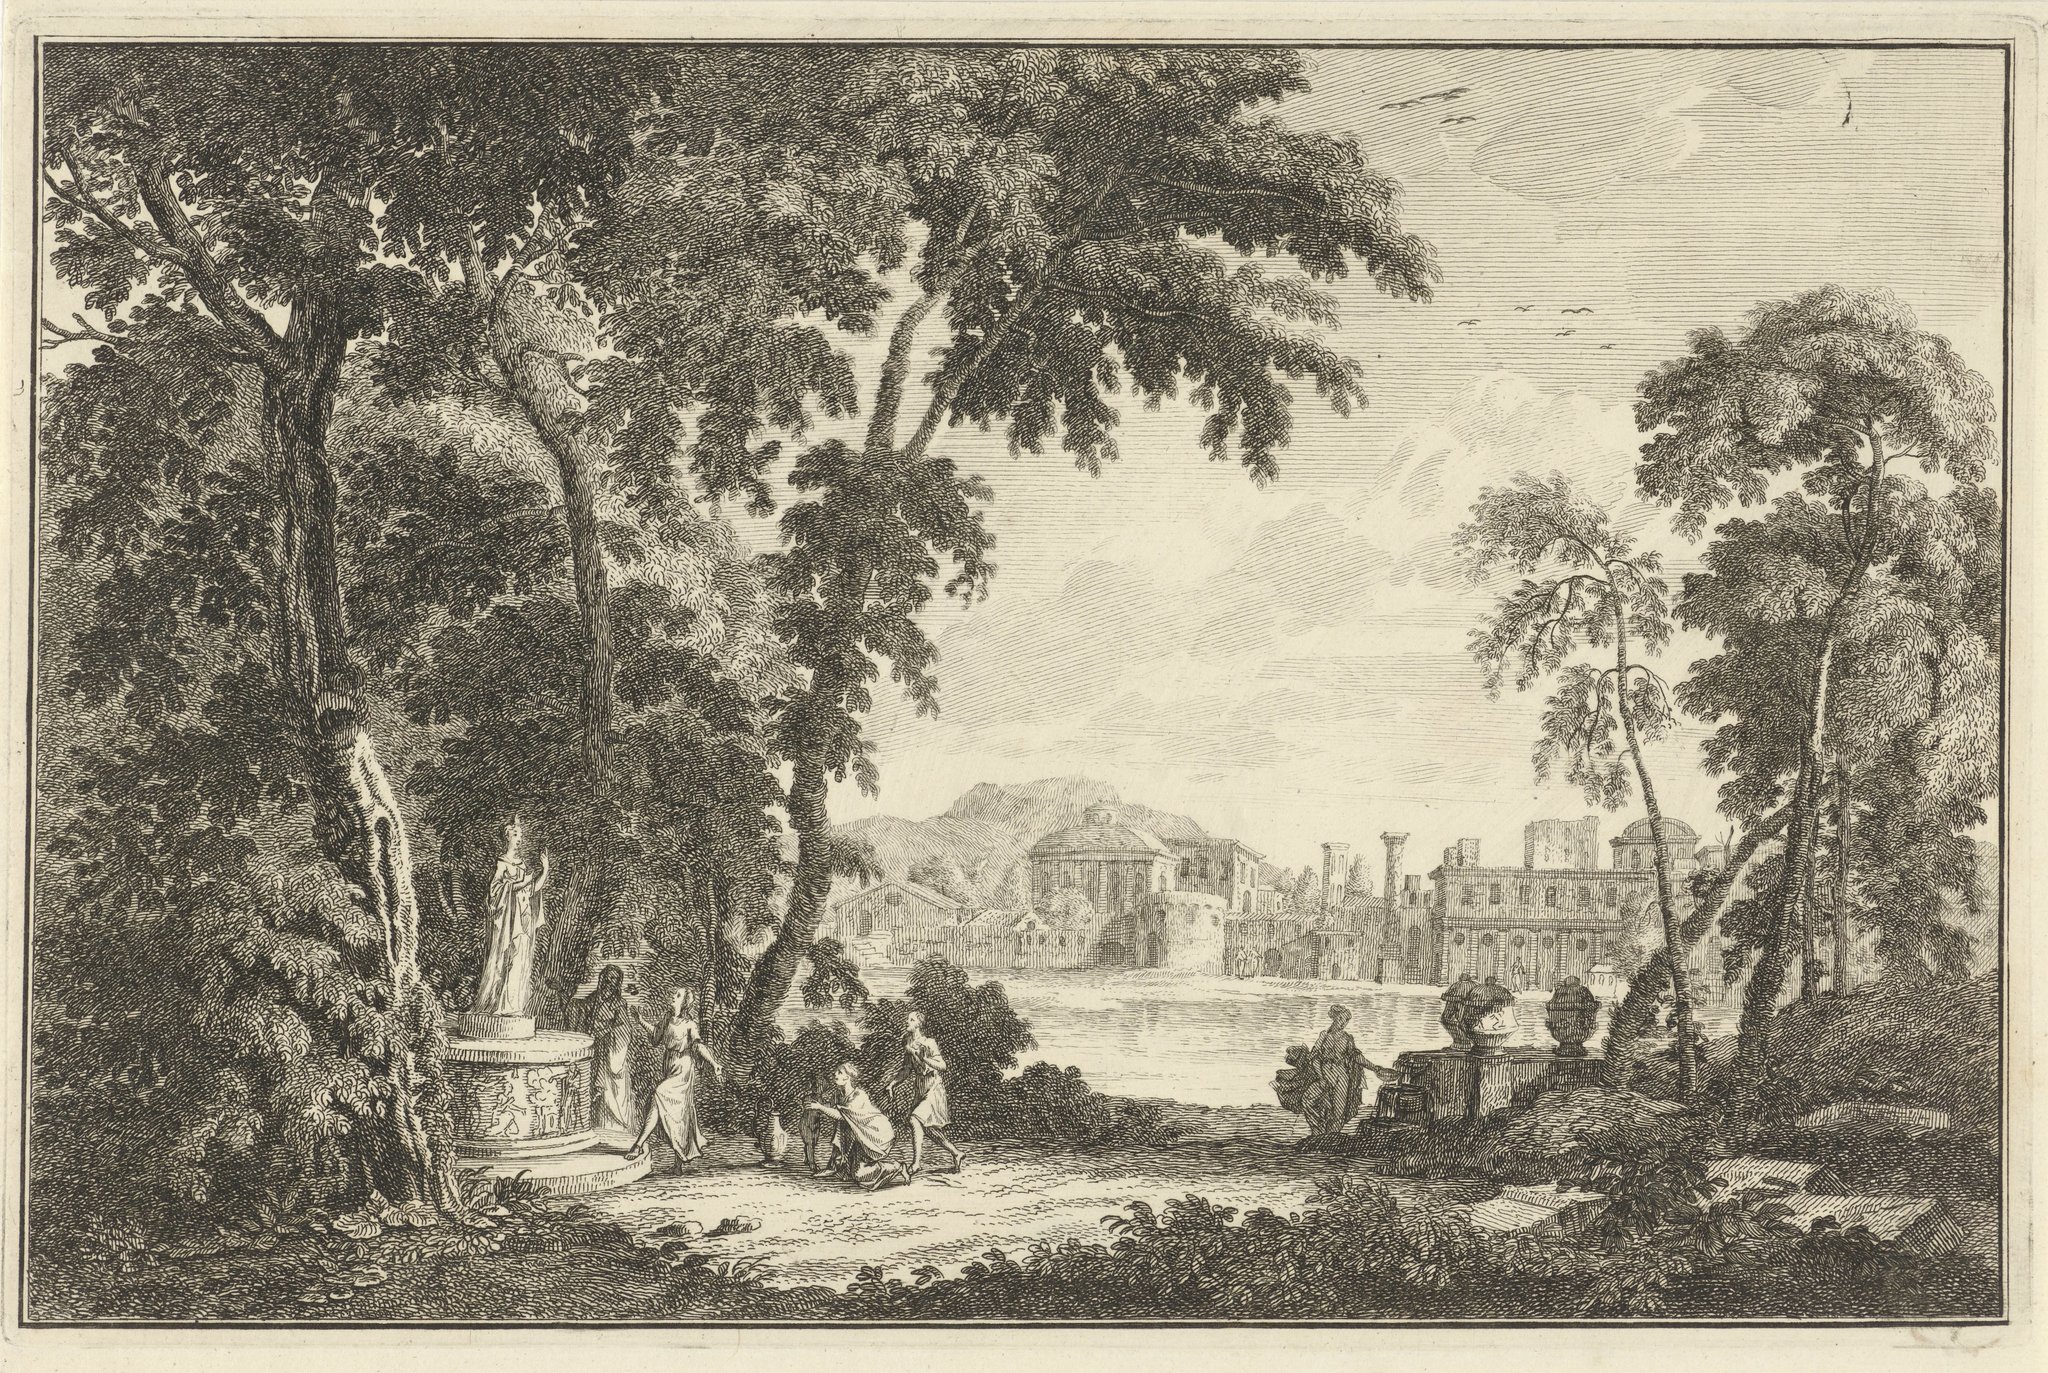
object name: print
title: Arcadisch rivierlandschap met figuren die een beeld aanbidden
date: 1710-1747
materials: paper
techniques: etching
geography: amsterdam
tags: landscapes with waters, waterscapes, seascapes (in the temperate zone), statues, paintings, etc. ~ objects of worship in roman religion, utilitarian, public pump or water fountain, prospect of city, town panorama, silhouette of city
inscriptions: collector's mark: Lugt 240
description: Arcadisch rivierlandschap met diverse figuren die een beeld aanbidden. Rechts een vrouw bij een bron, aan de overkant van de rivier ligt een stad. De prent maakt deel uit van een 40-delige serie prenten met voorstellingen van Italiaanse en Duitse landschappen.